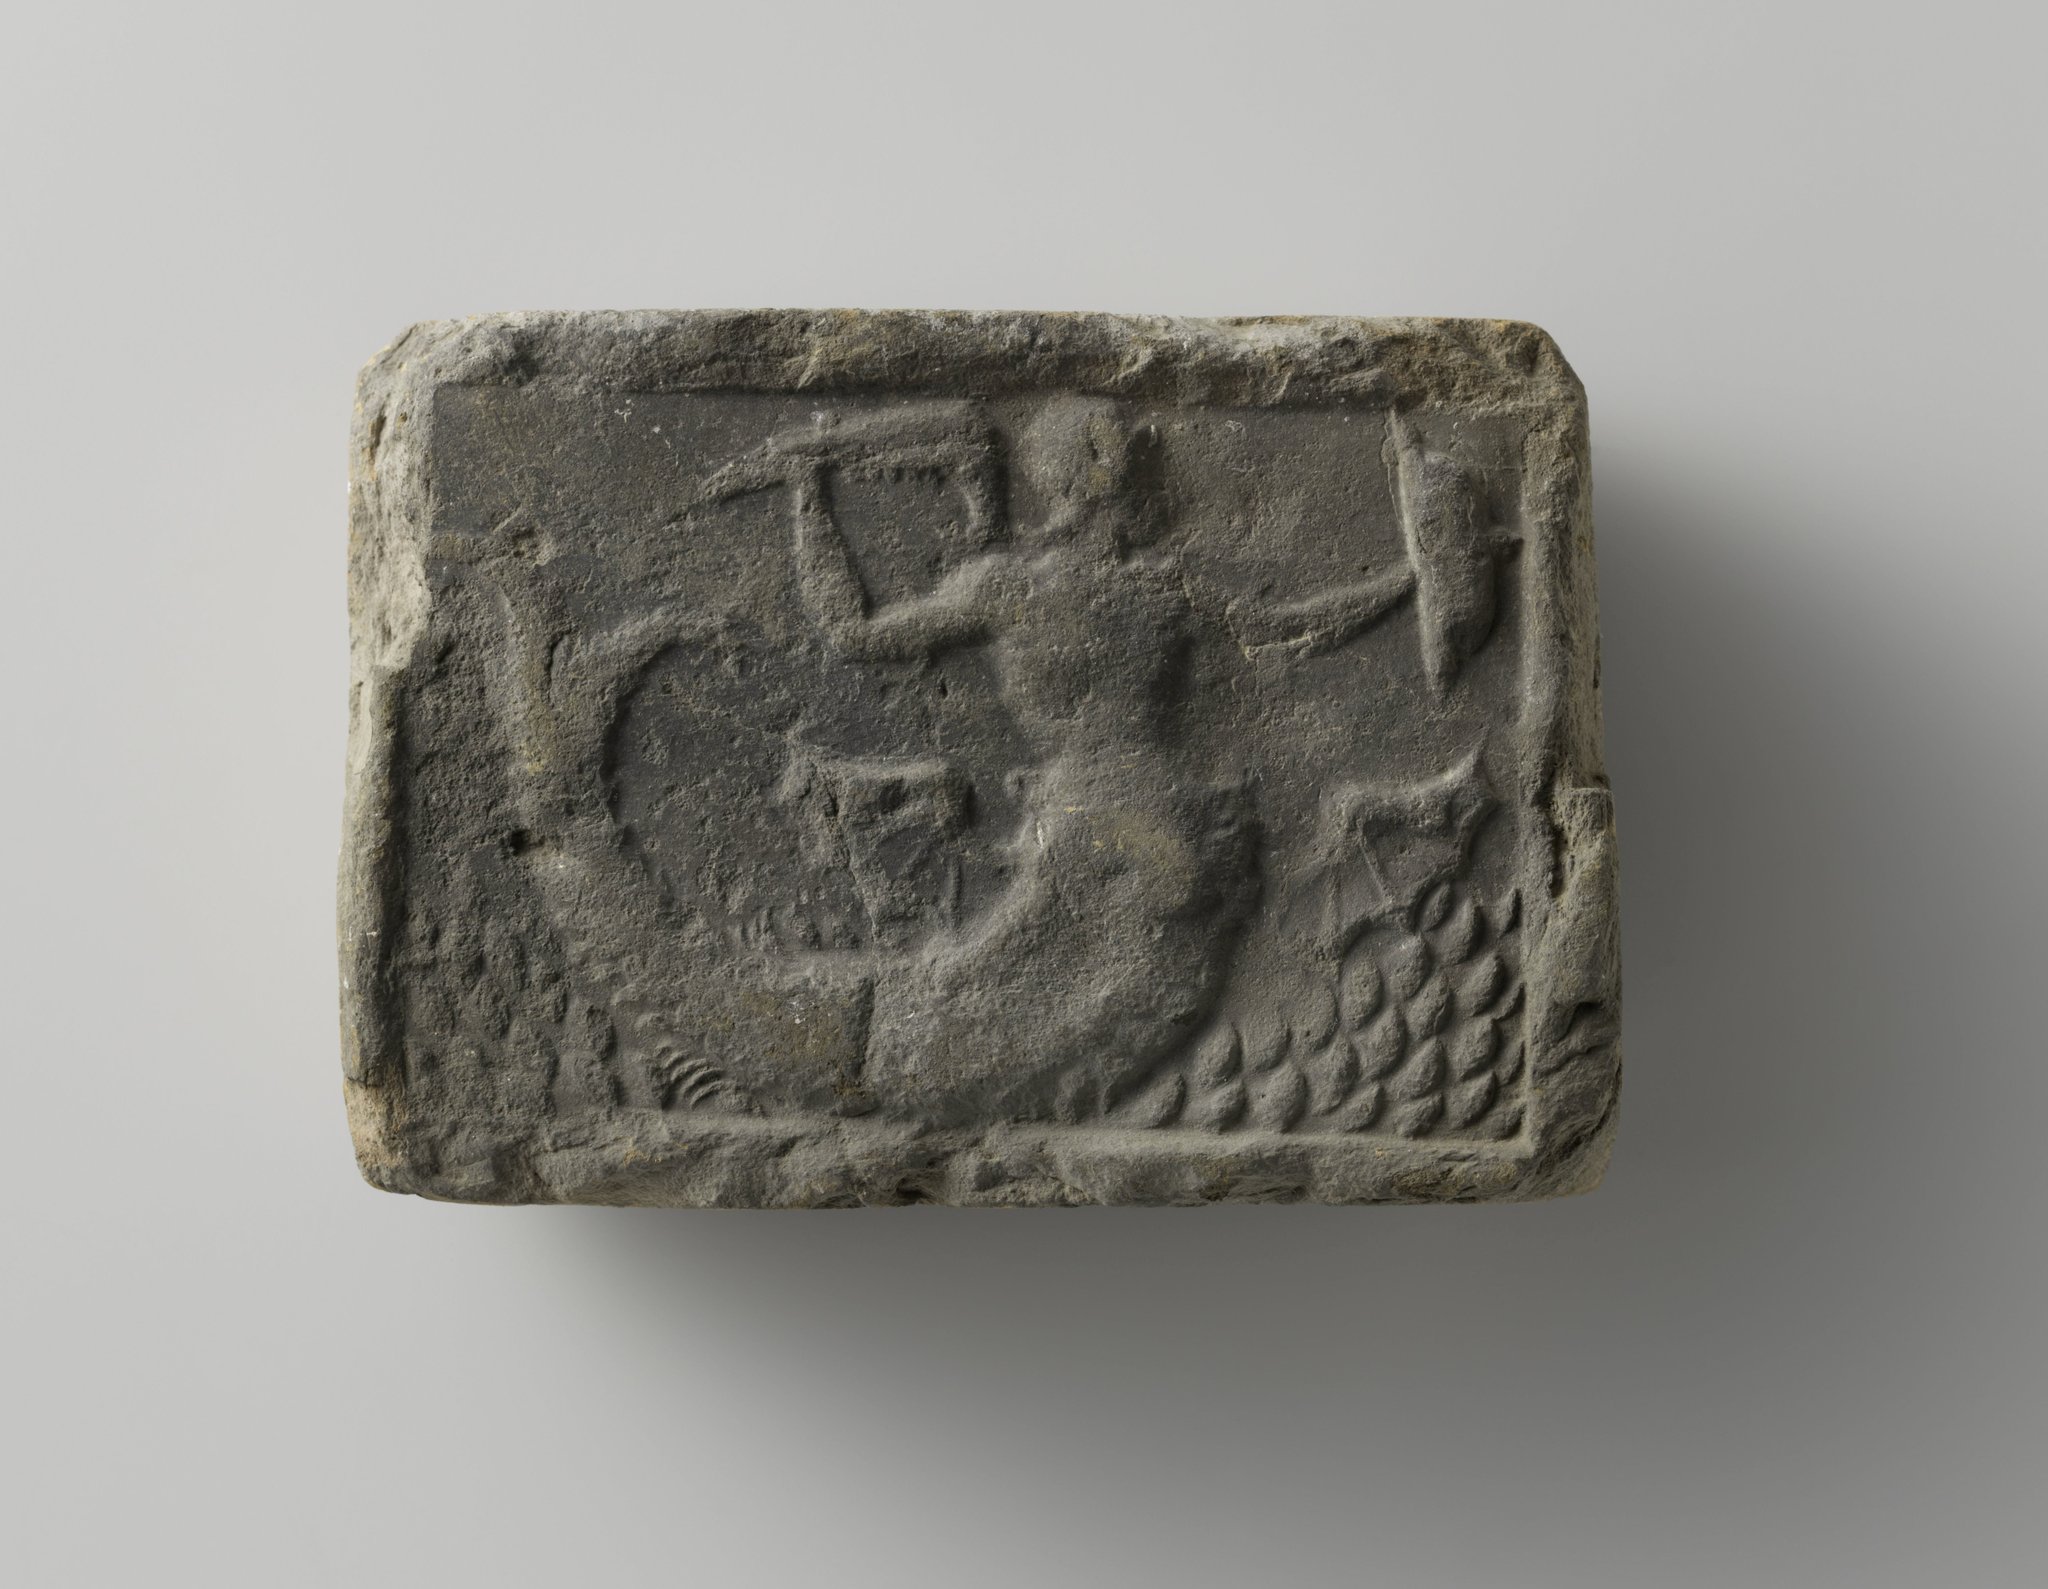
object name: hearthstone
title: Haardsteen met afbeelding van een meermin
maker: Anonymous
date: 1400-1950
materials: earthenware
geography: southern netherlands